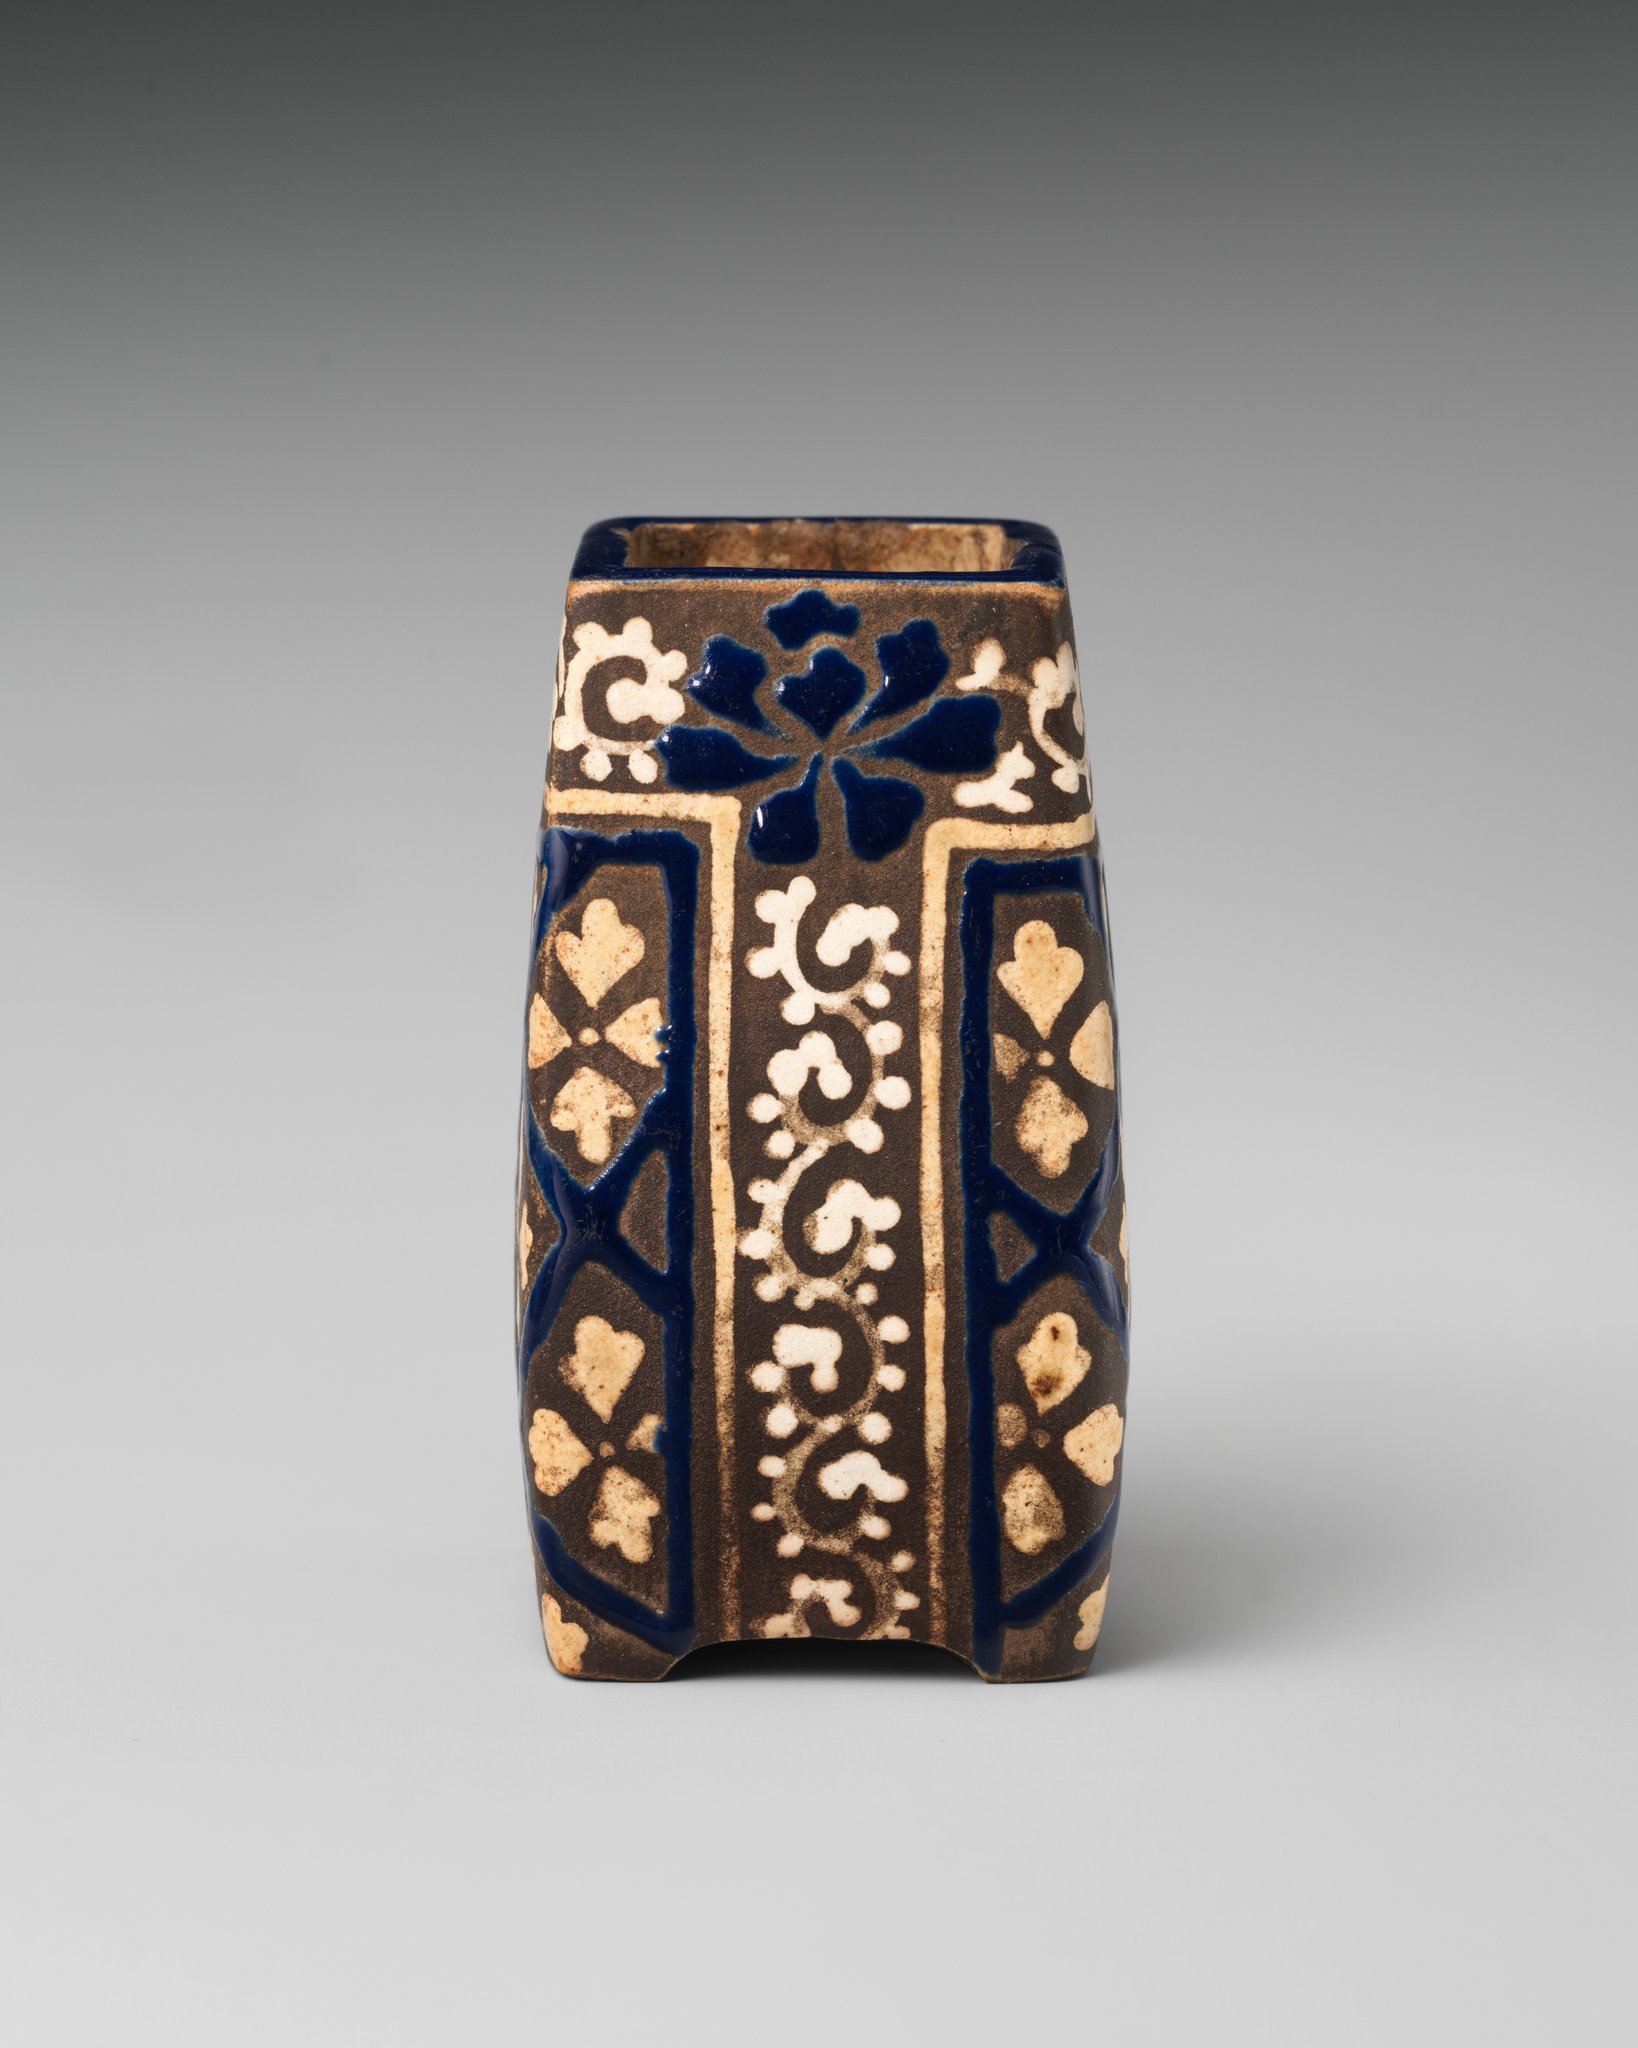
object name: incense stick burner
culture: japanese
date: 1701-1800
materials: pottery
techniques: glazing